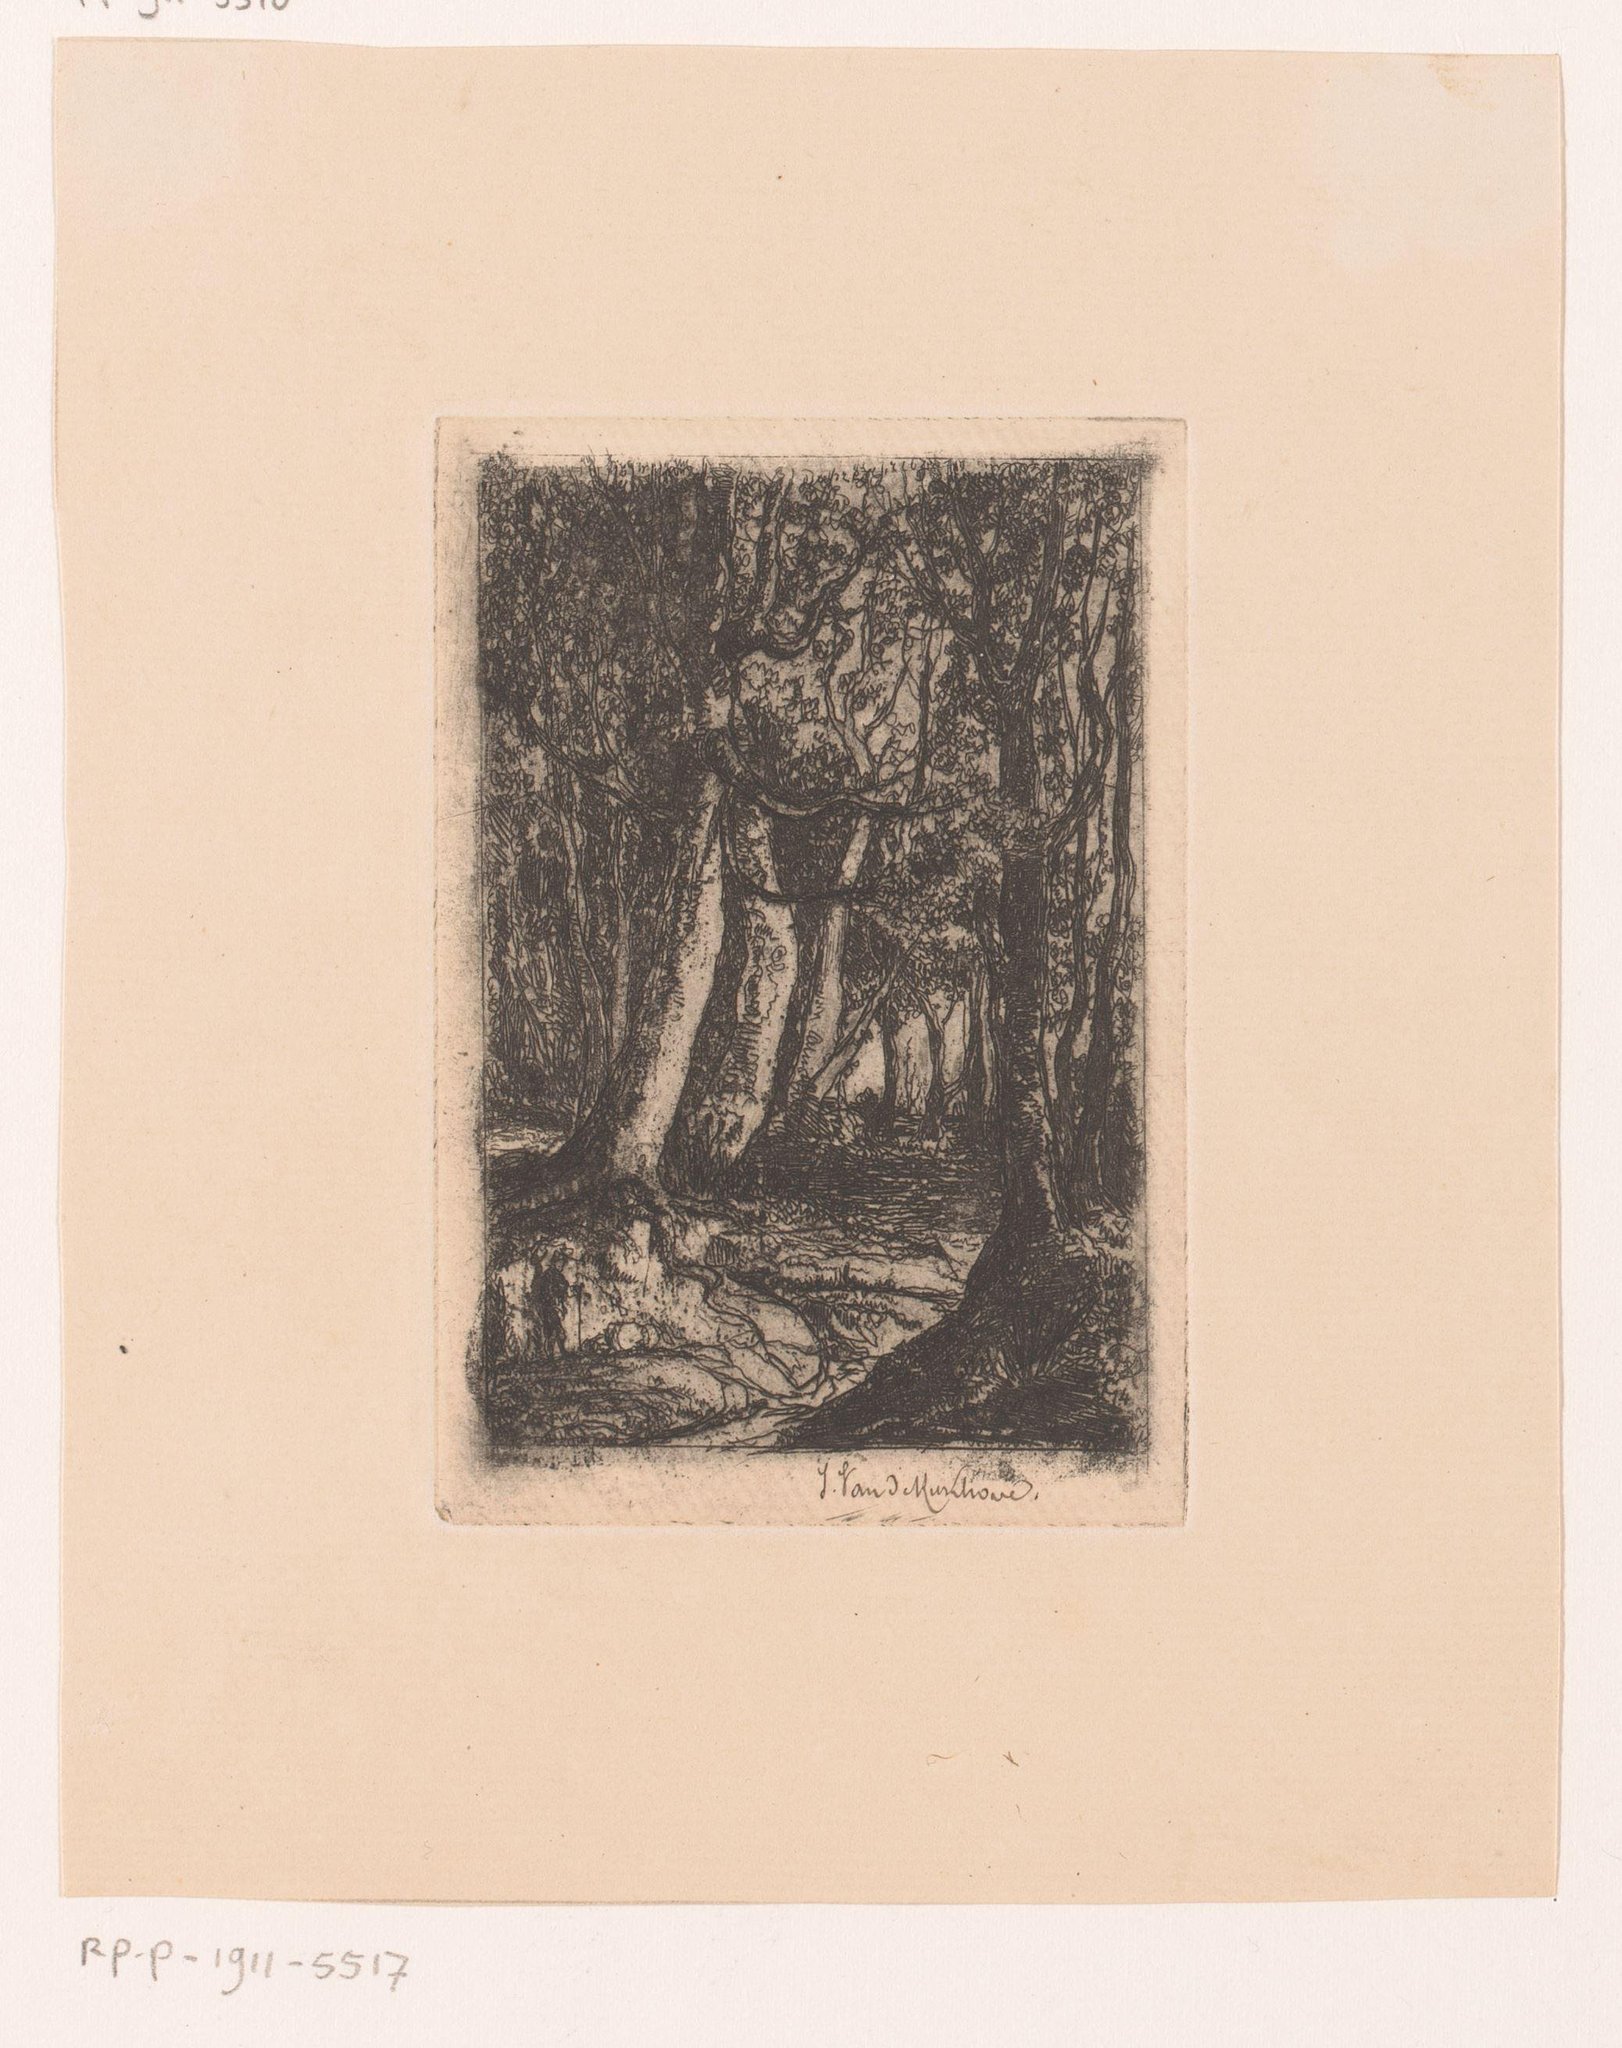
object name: print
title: Bospad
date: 1874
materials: paper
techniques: drypoint, etching, intaglio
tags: forest path or lane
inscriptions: collector's mark: Lugt 2228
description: De etsen naar de schilderijen van Frédéric Van de Kerkhove werden na zijn dood door zijn vader en zuster gemaakt en uitgegeven in twee reeksen. De eerste werd in 1877 uitgegeven door het Journal des Beaux-Arts et de la Littérature: Cahier de 25 Eaux-fortes d'après Frédéric van de Kerkhove, gravées par son père et sa sœur. De tweede reeks van 126 etsen, ook in 1877, werd in Parijs uitgegeven bij A. Lévy onder de titel Cent eaux-fortes gravées par J. Van de Kerkhove d'après les tableaux de Frédéric Van de Kerkhove, mort en 1873 à l'âge de 10 ans et 11 mois.